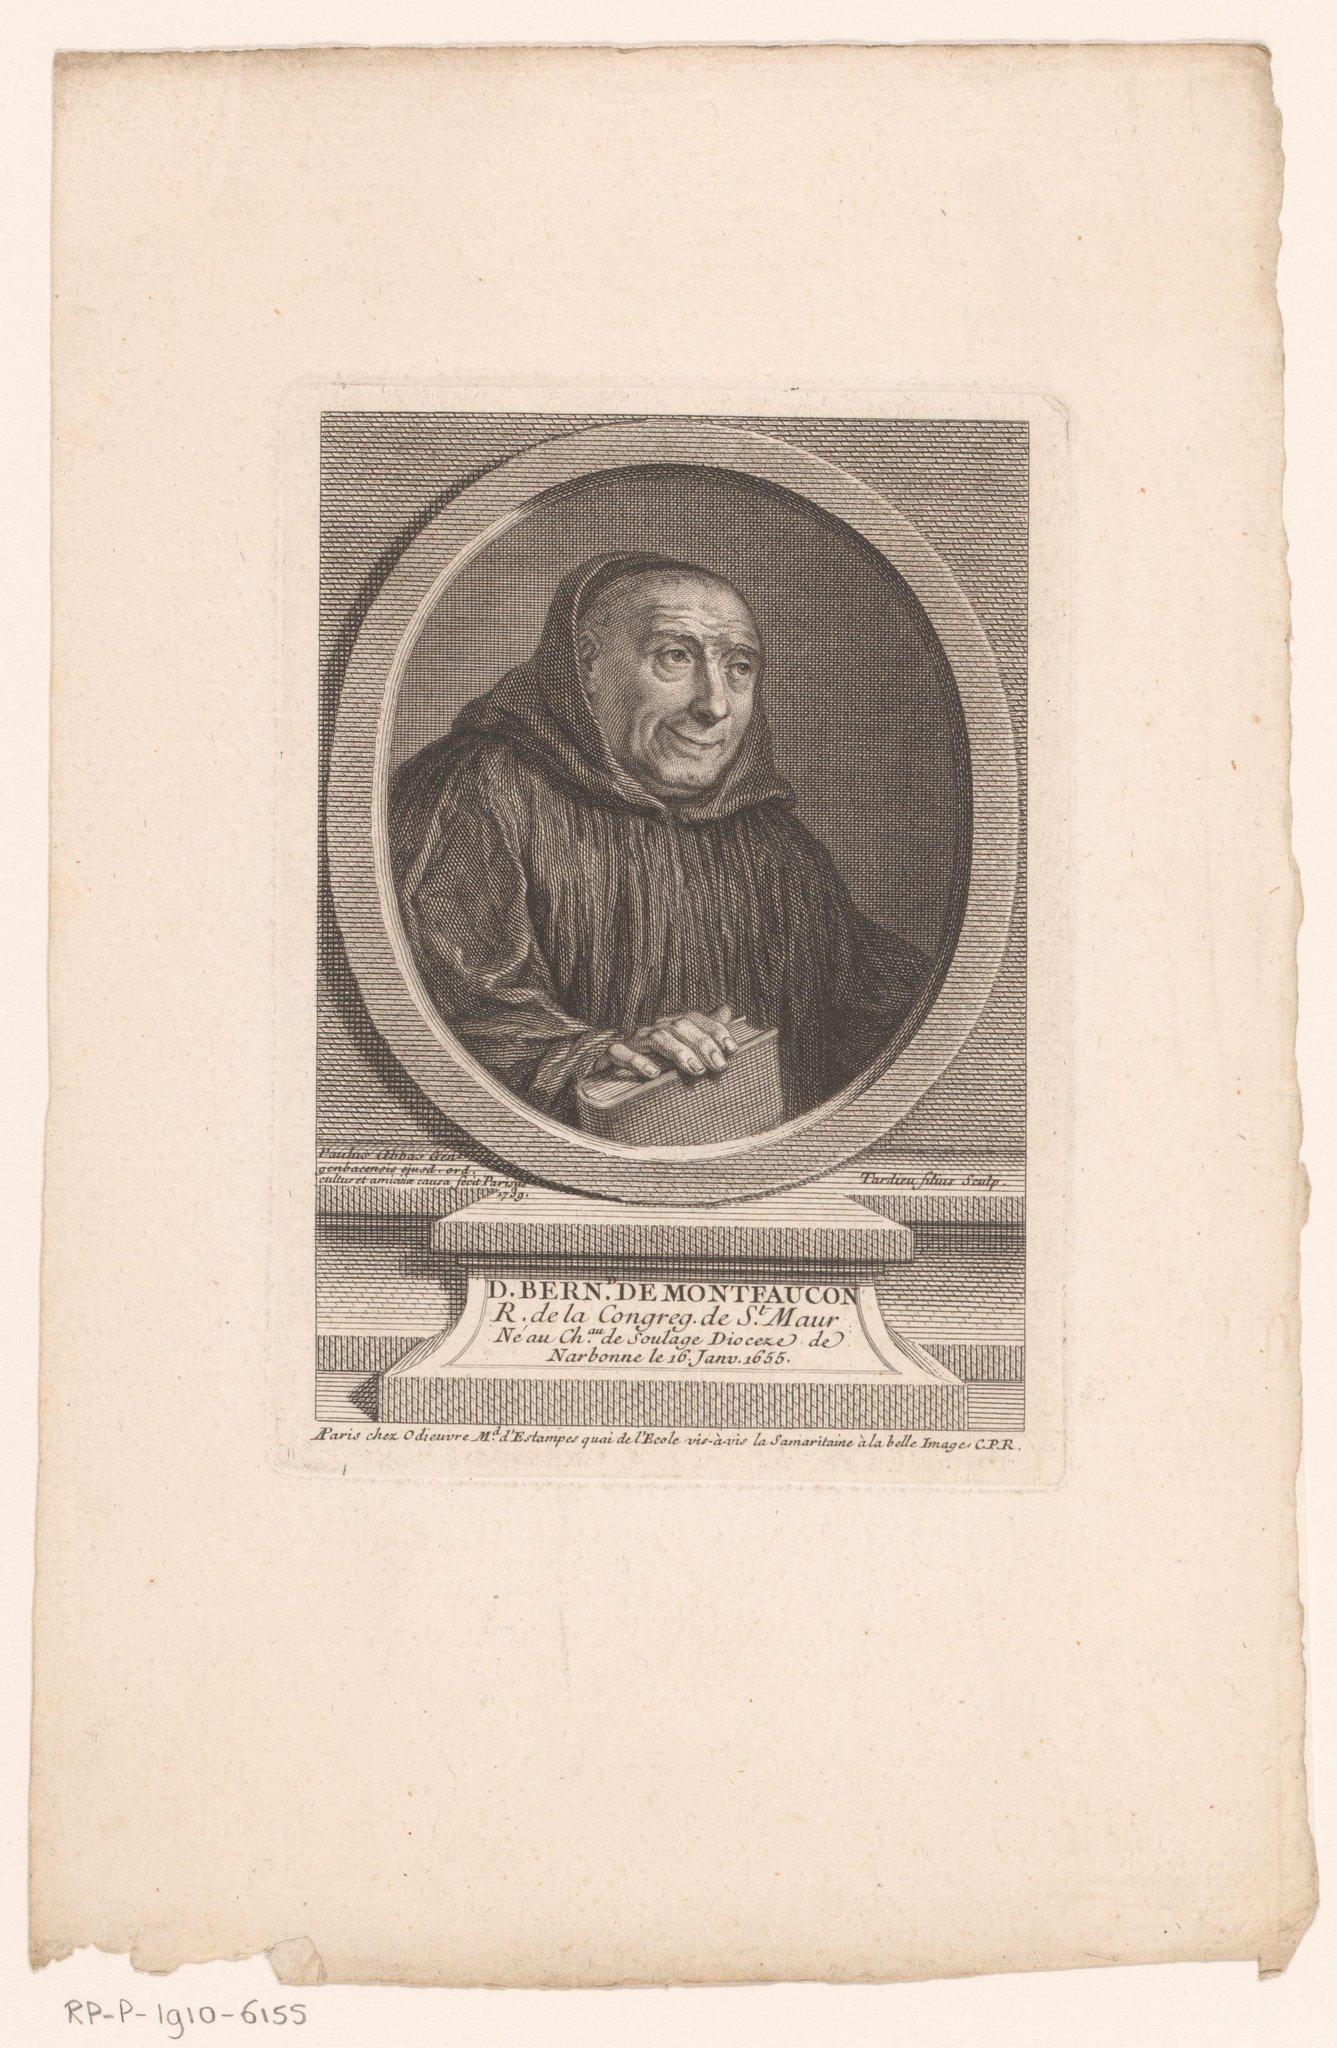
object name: print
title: Portret van Bernard de Montfaucon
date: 1755-1765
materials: paper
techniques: engraving, etching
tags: paris, abbot, historical persons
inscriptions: collector's mark: Lugt 2228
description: Prent als illustratie gebruikt voor het boek: Dreux de Radier, Jean François. L'Europe illustre. Parijs: Michel Odieuvre, 1755-1765.